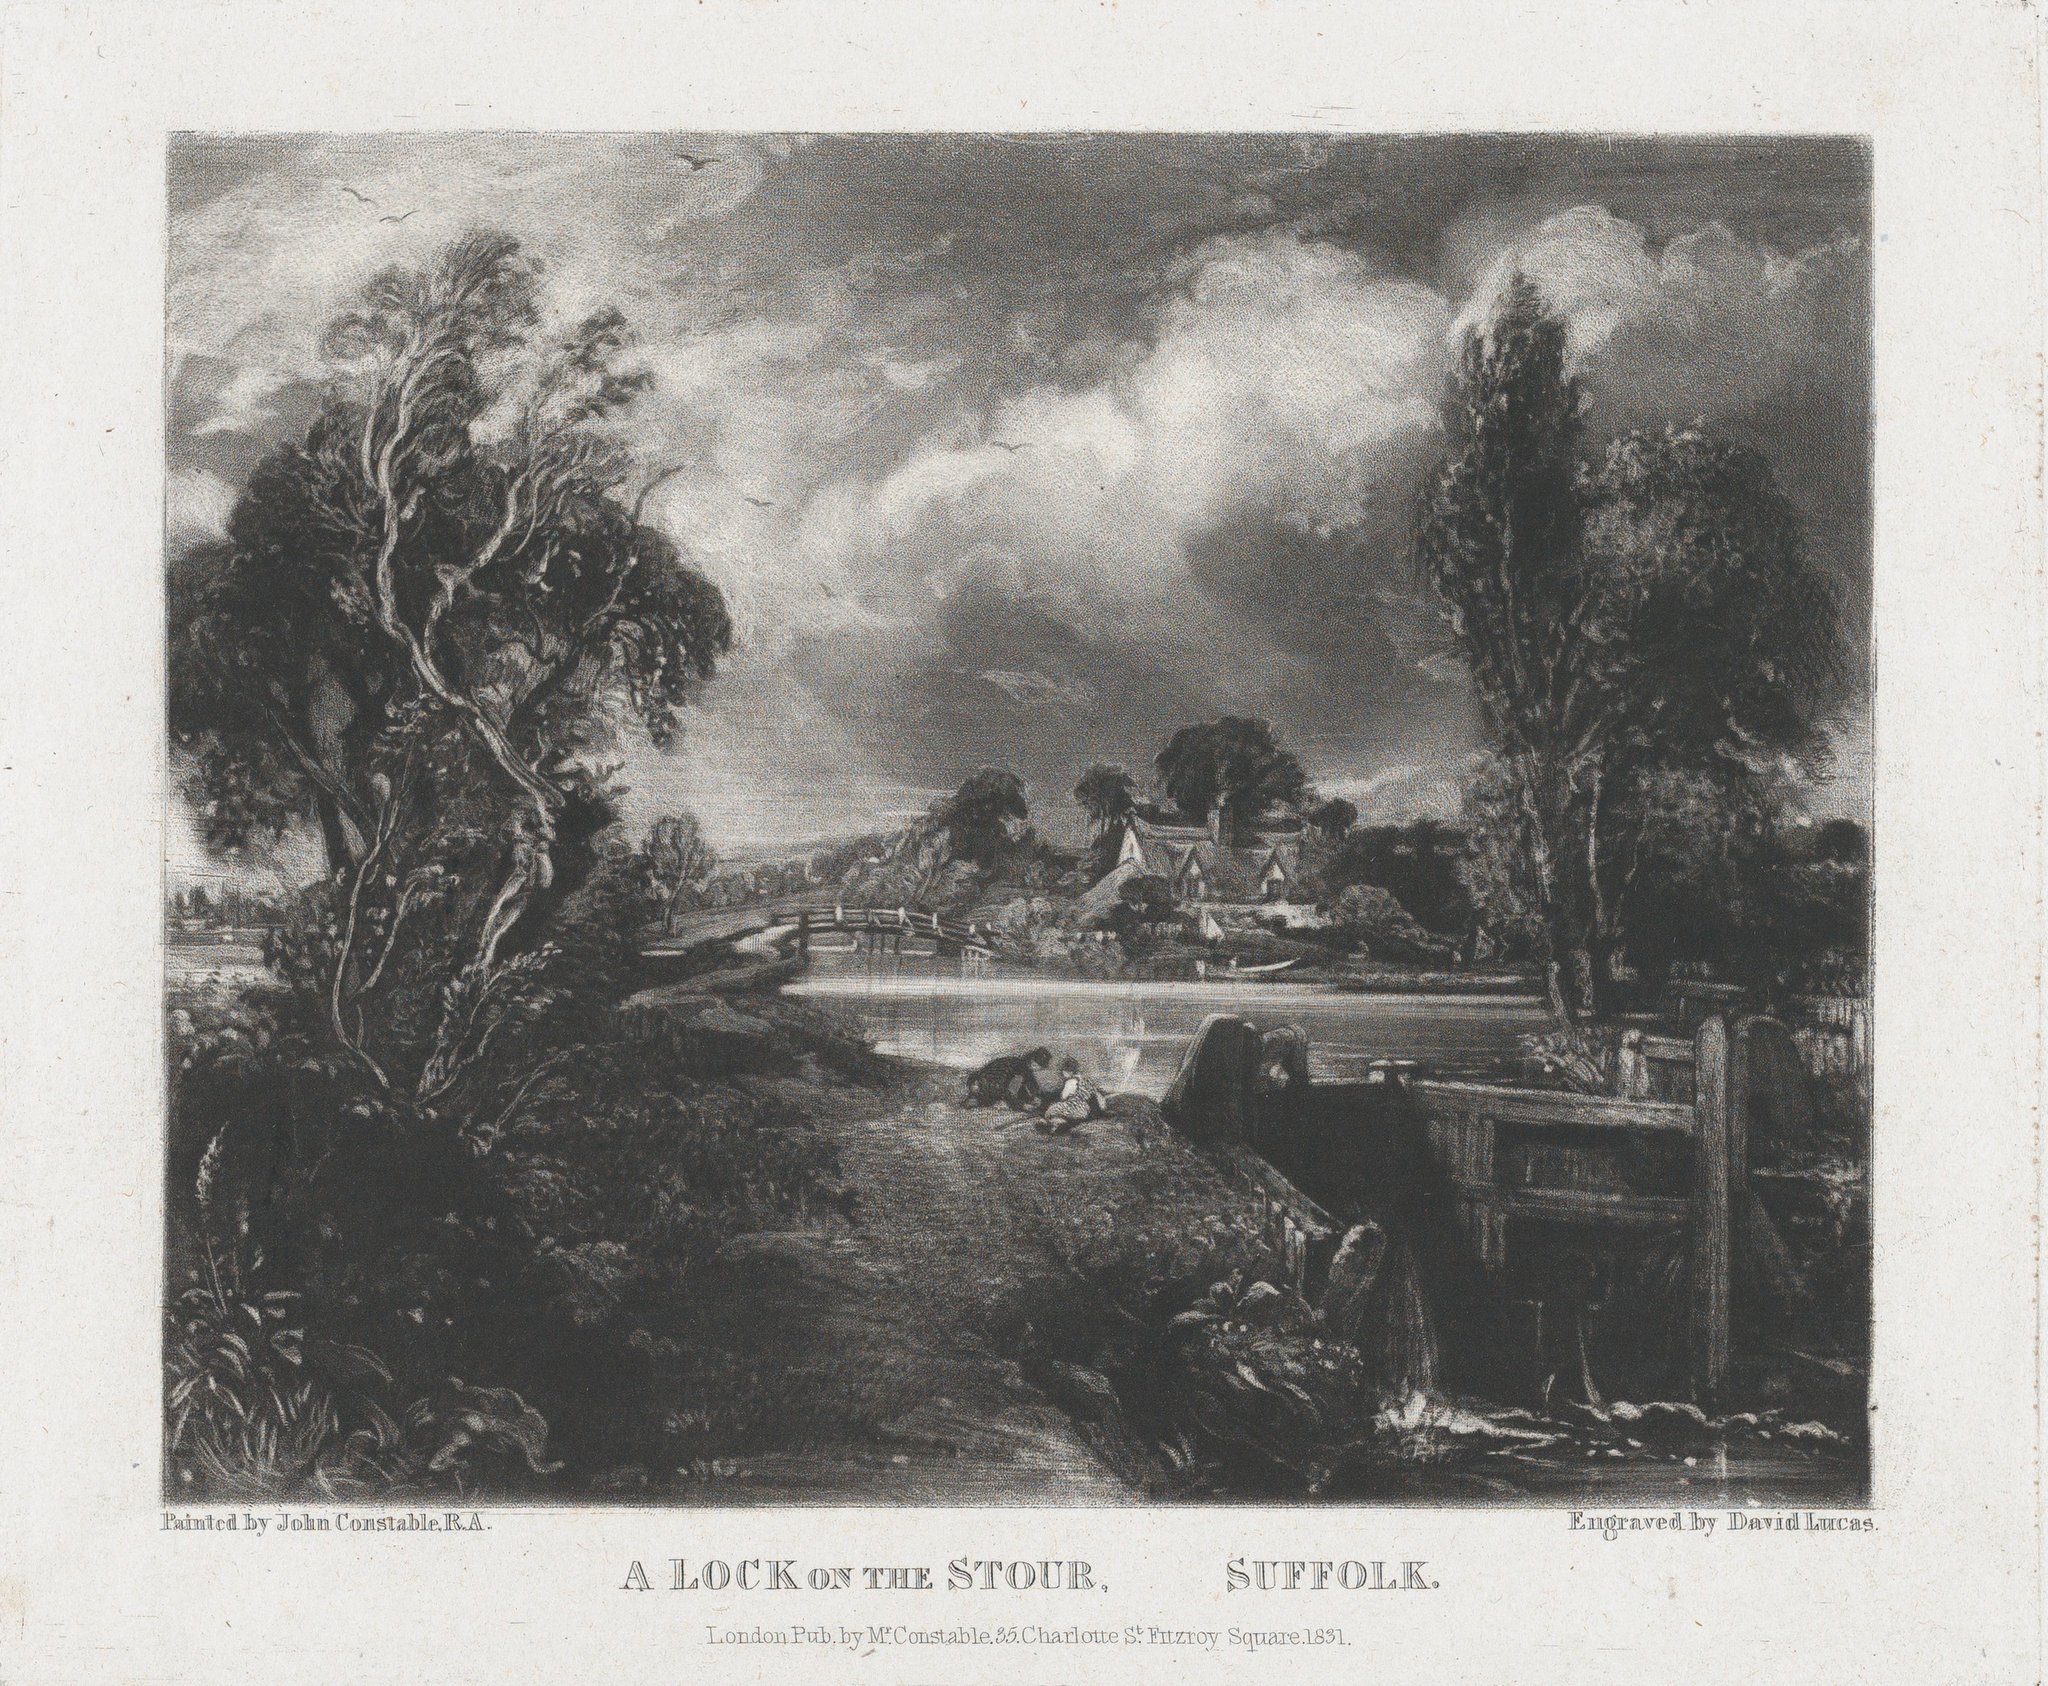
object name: print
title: A Lock on the Stour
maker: david lucas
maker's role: artist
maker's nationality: british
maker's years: 1802-1881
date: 1831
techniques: mezzotint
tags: human figures,bridges,rivers,landscapes,trees